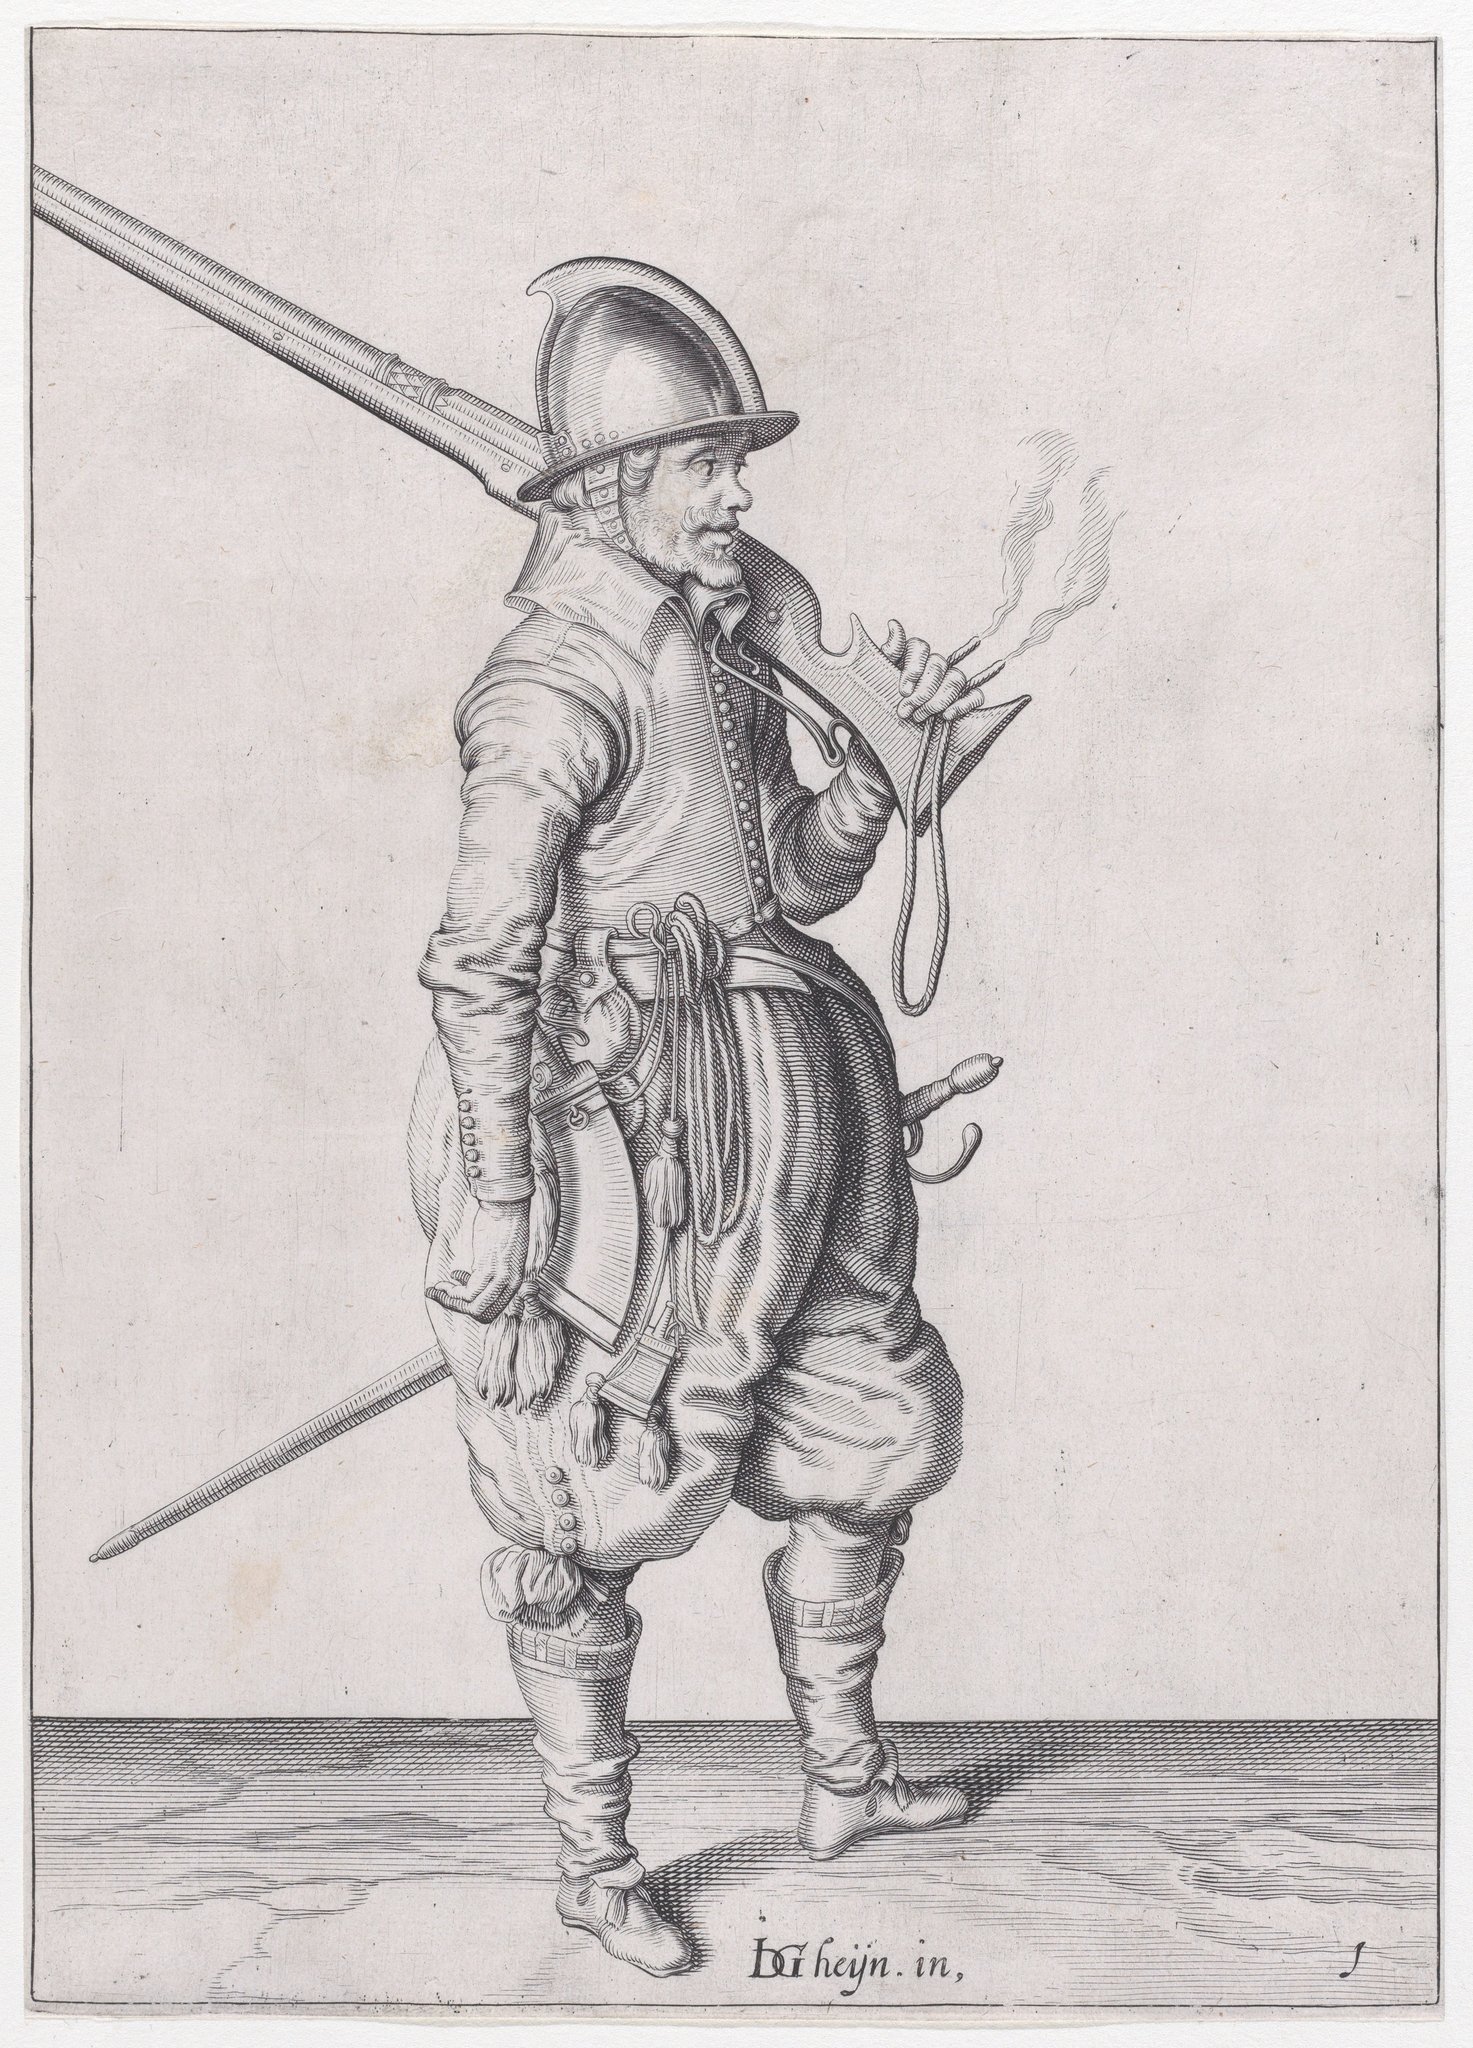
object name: print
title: A soldier holding his caliver, from the Marksmen series, plate 1, in Waffenhandlung von den Rören Musquetten undt Spiessen / Wapenhandelinghe van Roers Musquetten Ende Spiessen (The Exercise of Arms)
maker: jacques de gheyn (ii)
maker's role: artist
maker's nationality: netherlandish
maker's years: 1565-1629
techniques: engraving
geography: the hague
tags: soldiers,firearms,men